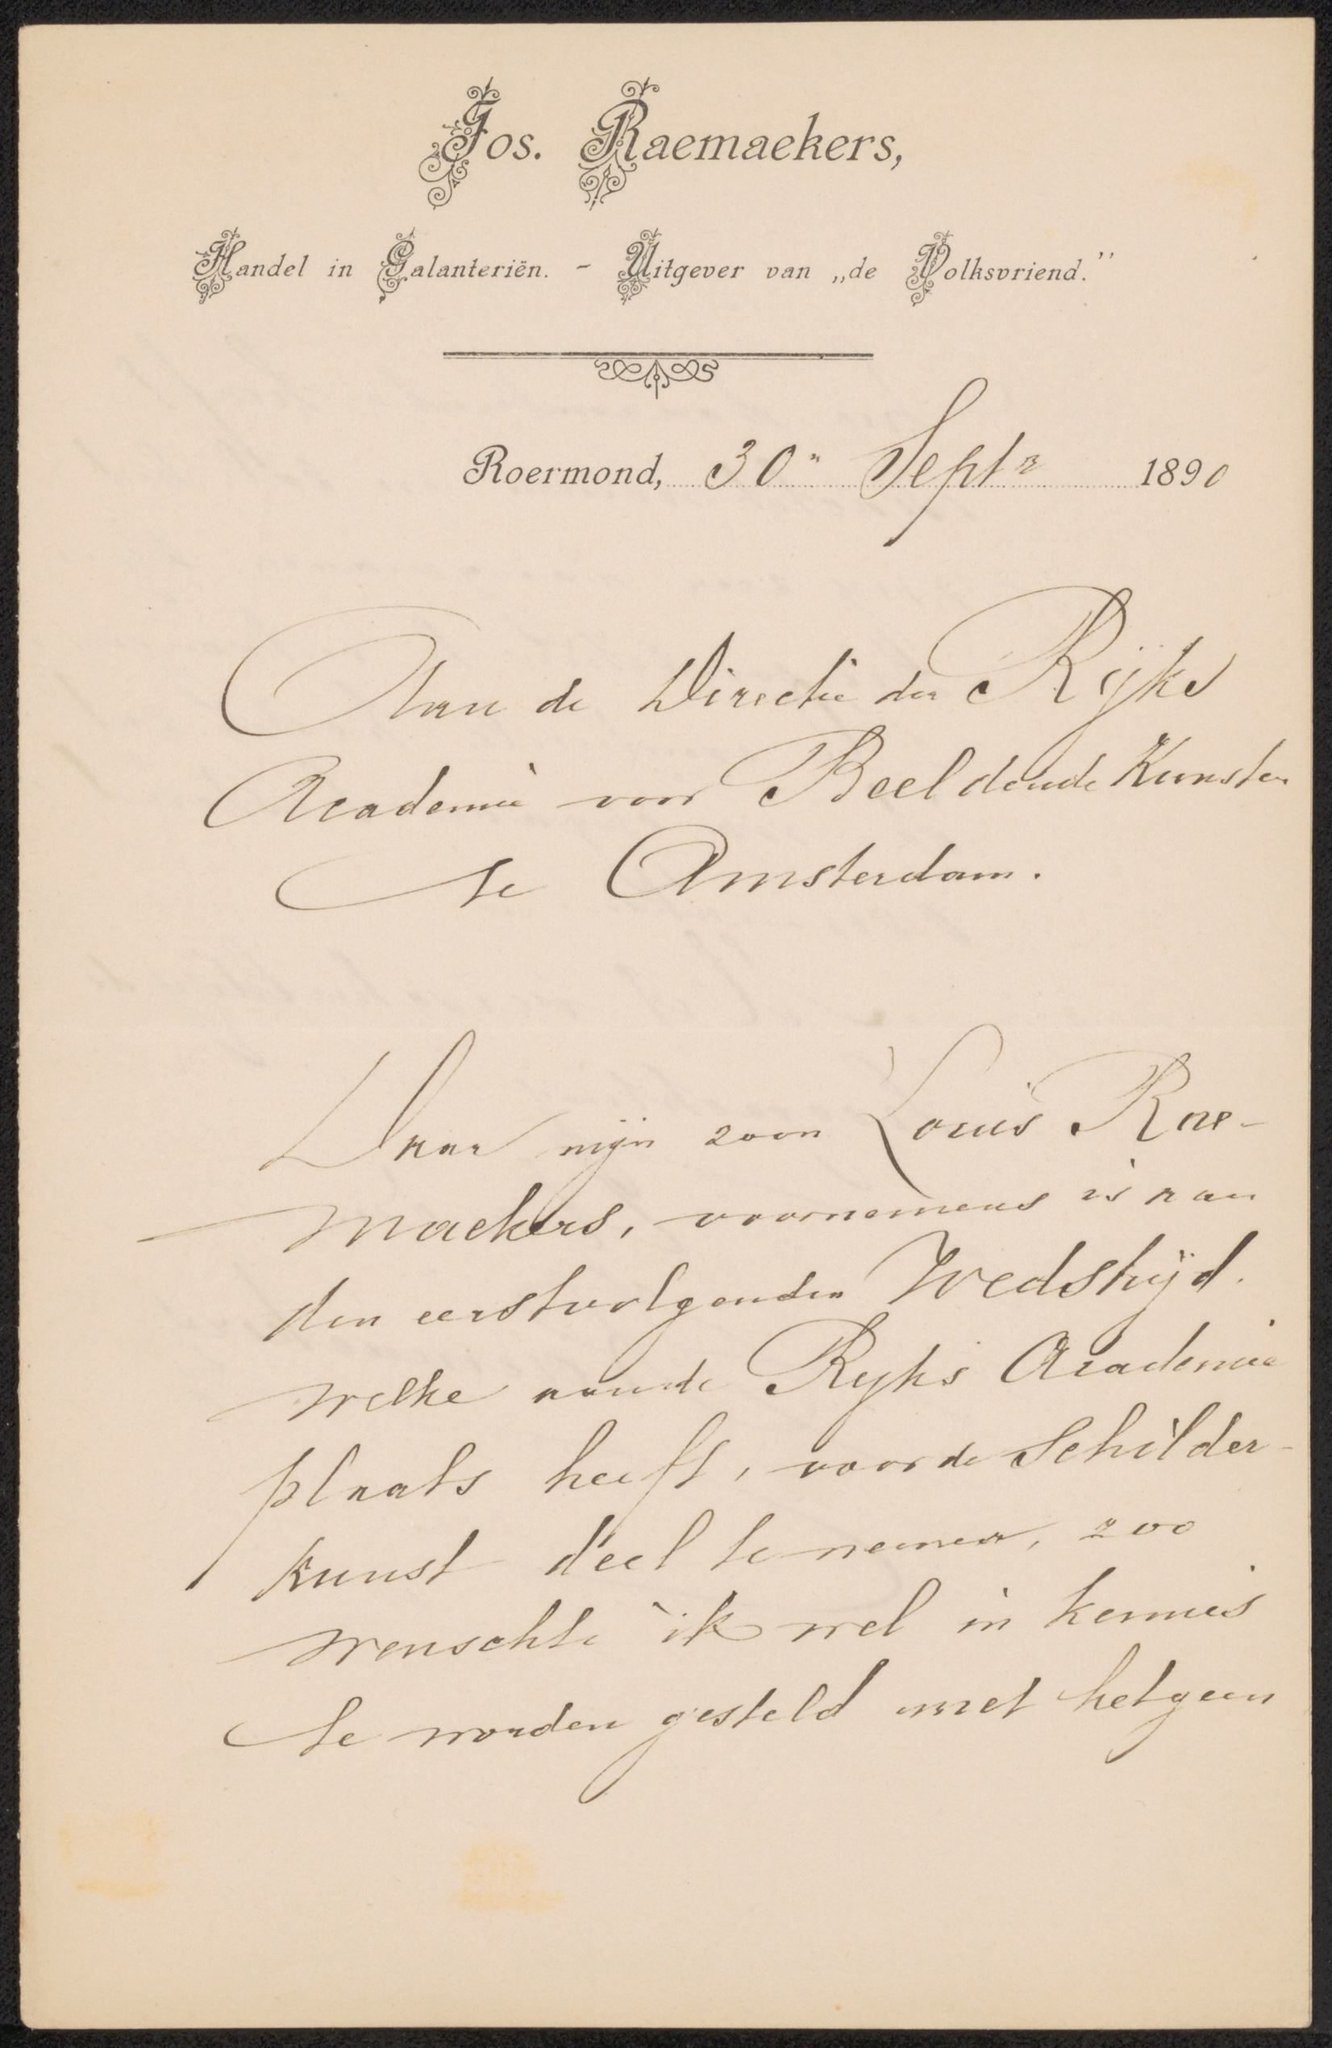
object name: letter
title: Brief aan August Allebé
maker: jos. raemaekers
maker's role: publisher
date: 1890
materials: ink, paper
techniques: pen, printing, writing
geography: roermond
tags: amsterdam, print maker, august allebé, draughtsman, louis raemaekers, distribution of awards ~ art contest, painting (including book-illumination, miniature-painting)